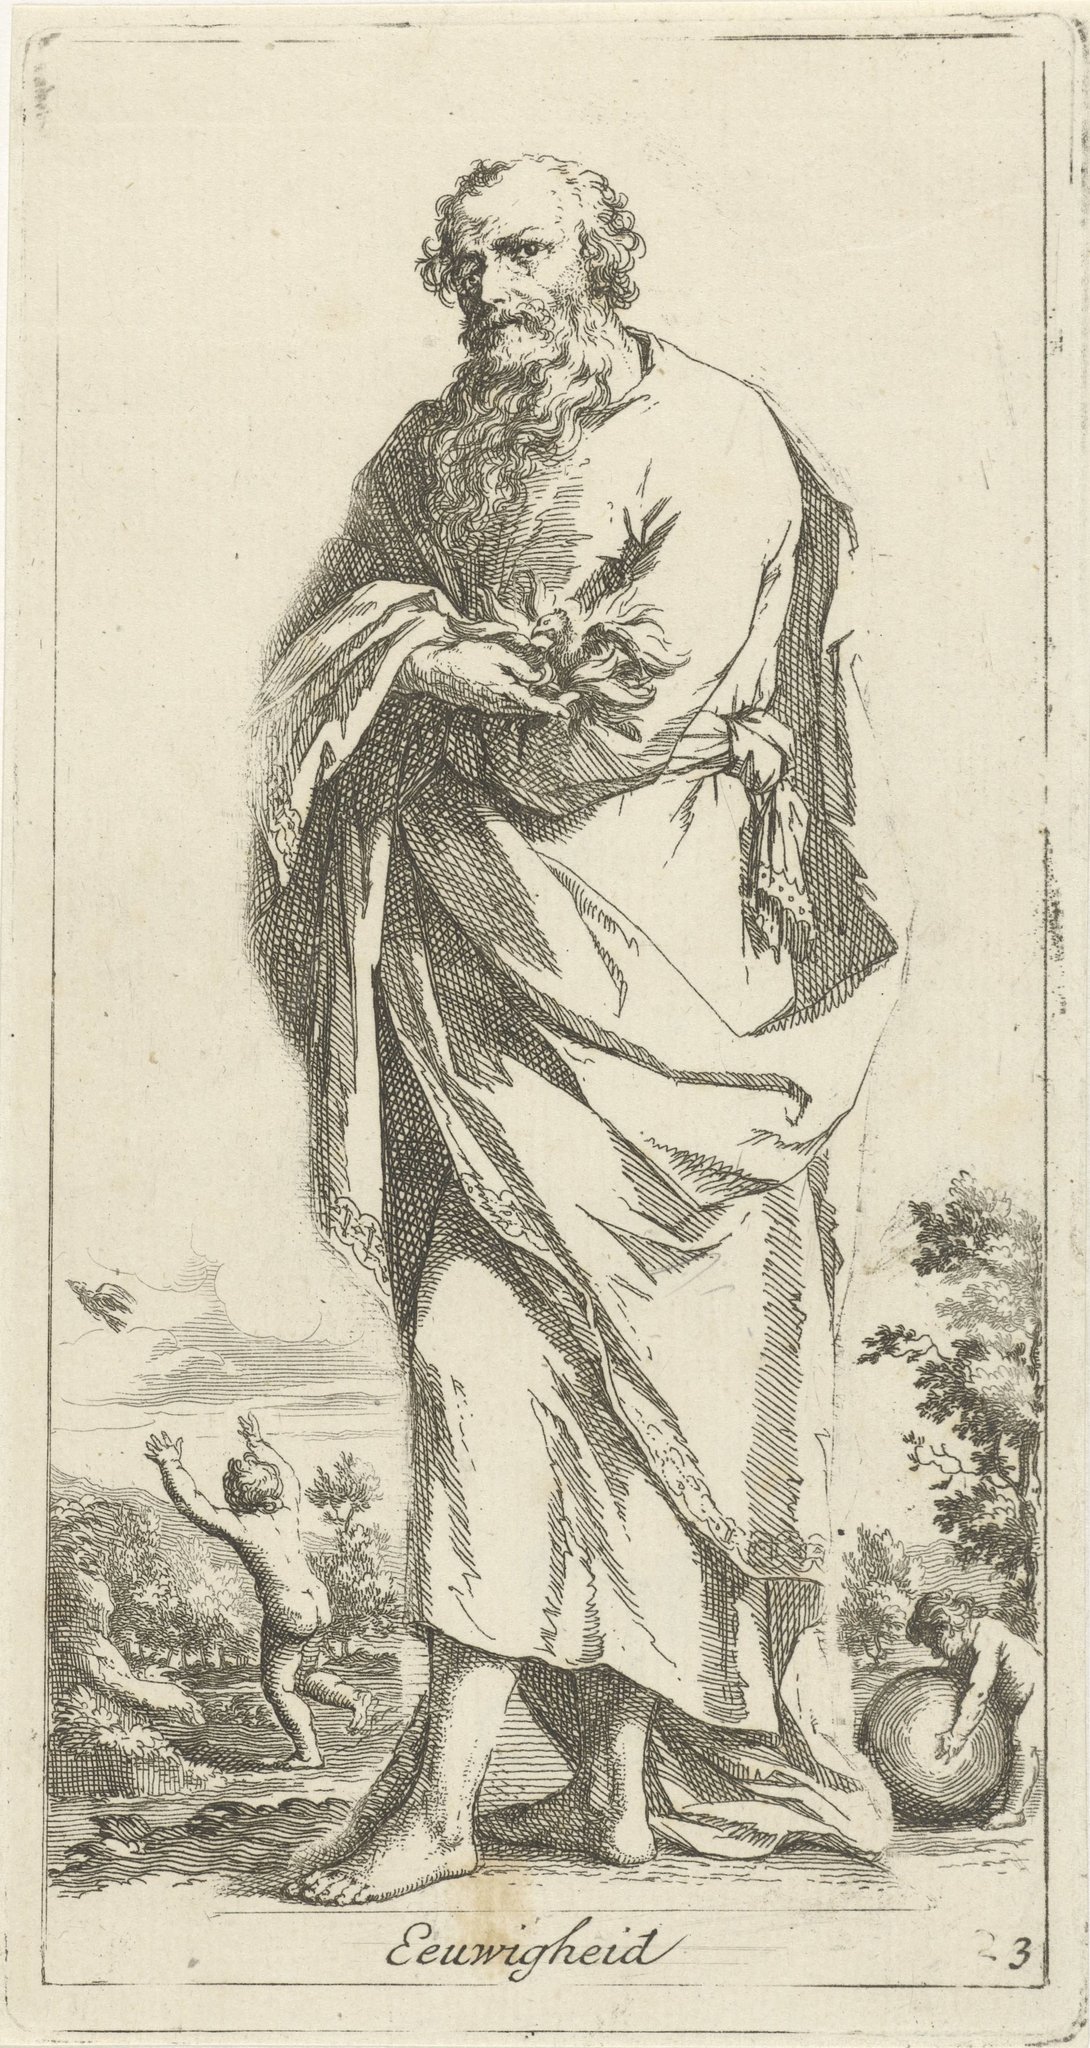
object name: print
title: Eeuwigheid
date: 1710-1719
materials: paper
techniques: etching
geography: amsterdam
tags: birds, eternity, 'aeternitas'; 'eternità','eternità o perpetuità' (ripa)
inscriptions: collector's mark: Lugt 2228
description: Een man met baard als personificatie van de eeuwigheid met in zijn hand een feniks. Op de achtergrond twee blote kindfiguren; rechts omvat een een wereldbol en links rent de tweede achter een vliegende vogel aan. Prent uit een serie van 41 zinnebeelden.